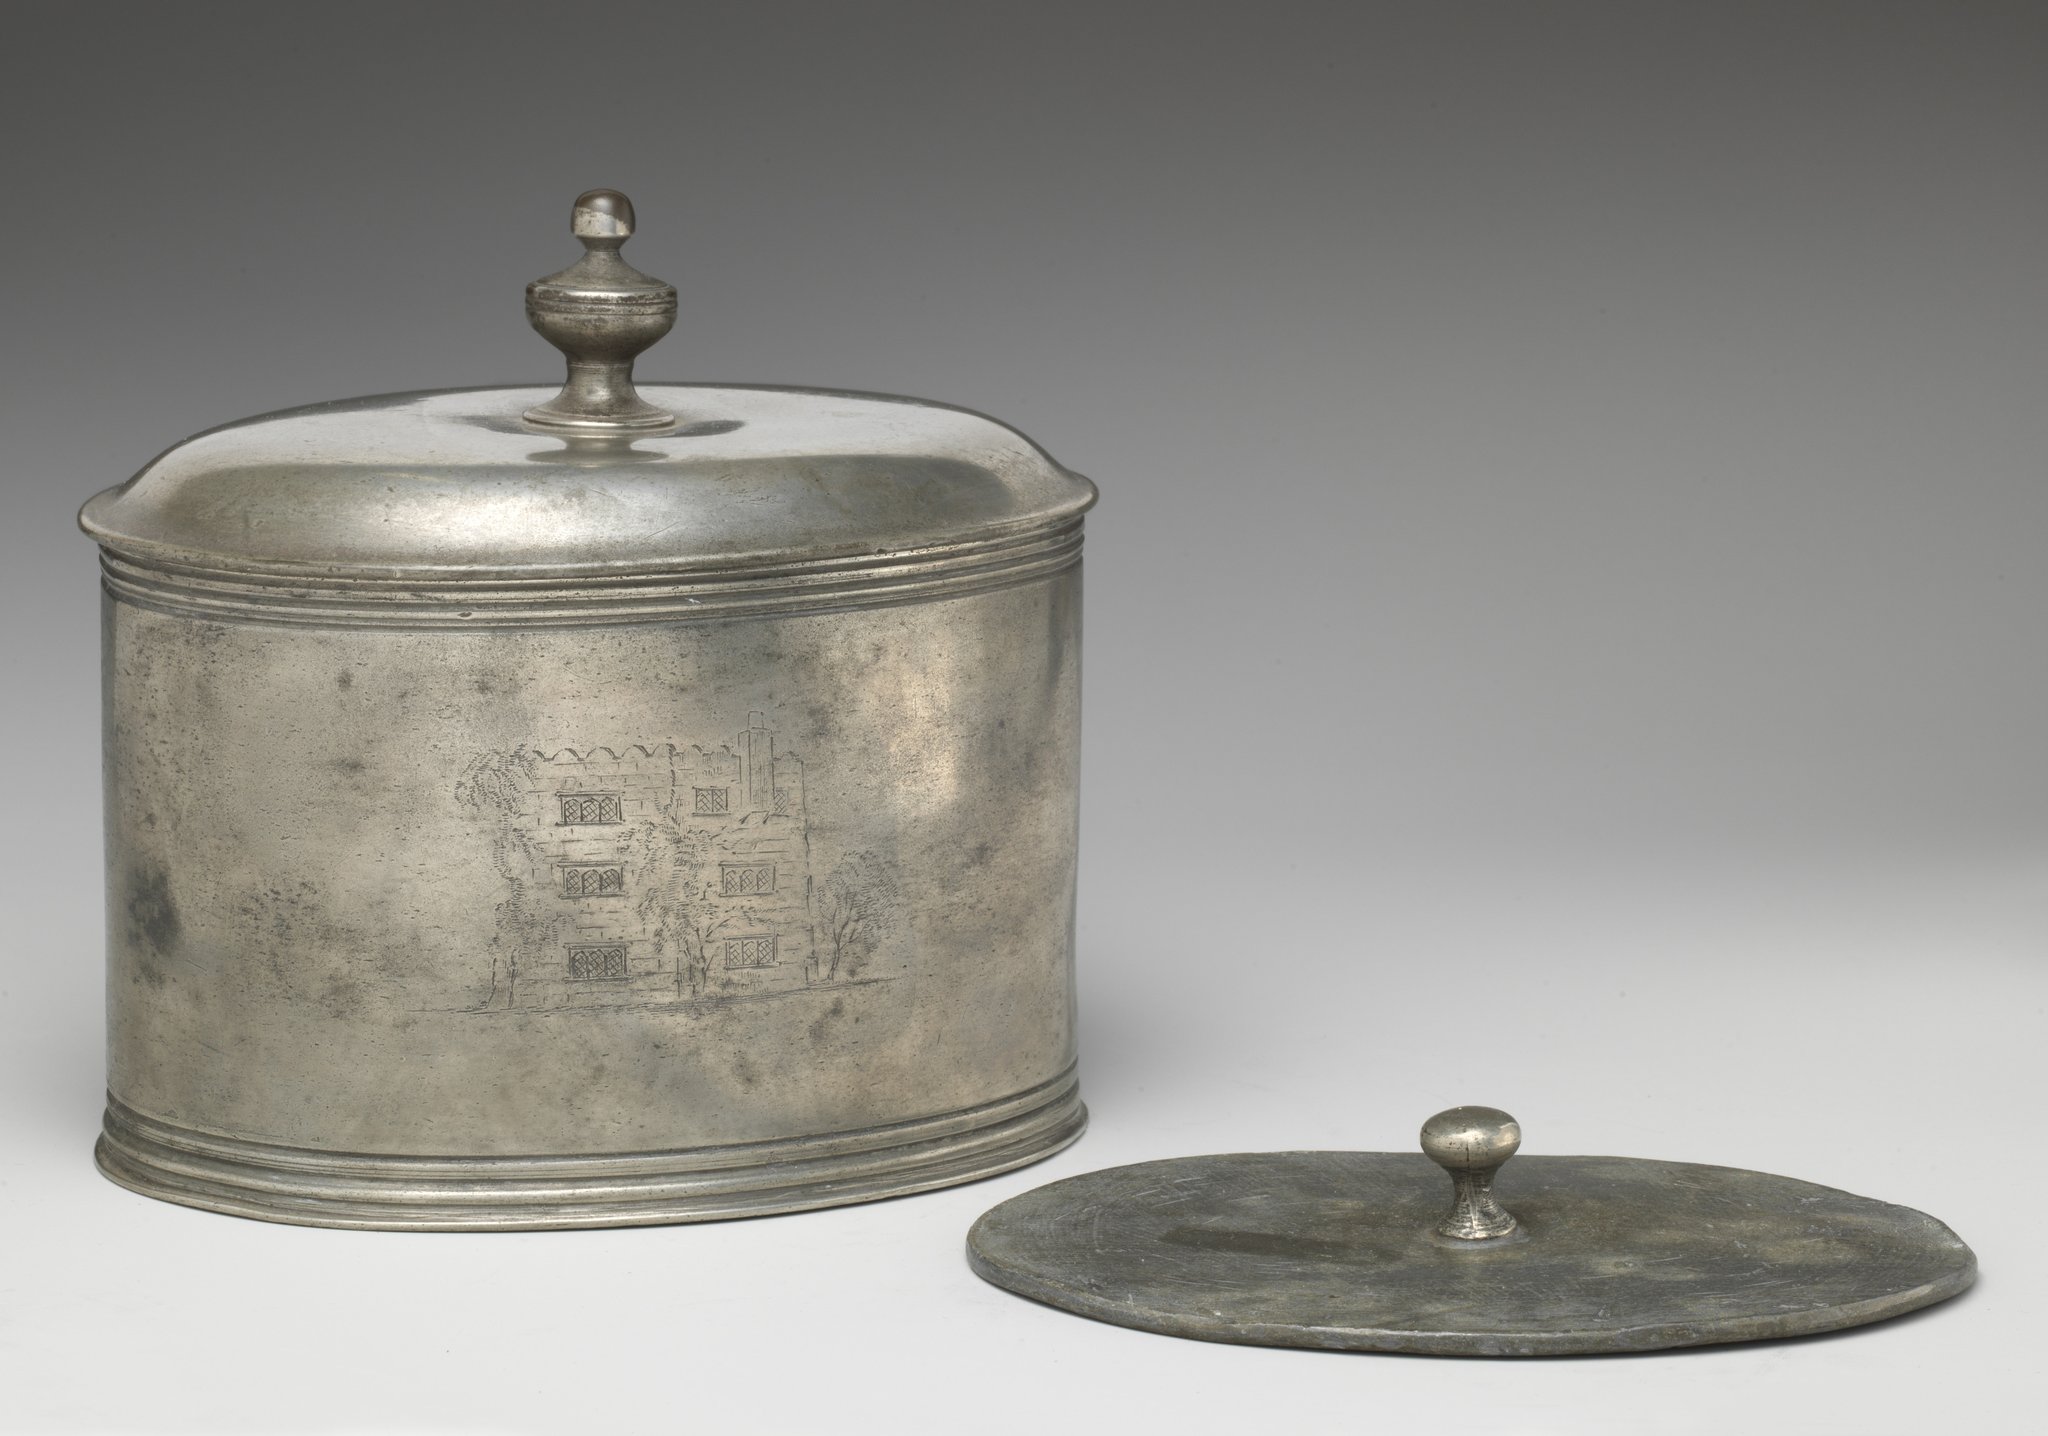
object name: tobacco box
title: Tobacco box with crest of Eyre family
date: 1767-1833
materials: pewter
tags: buildings